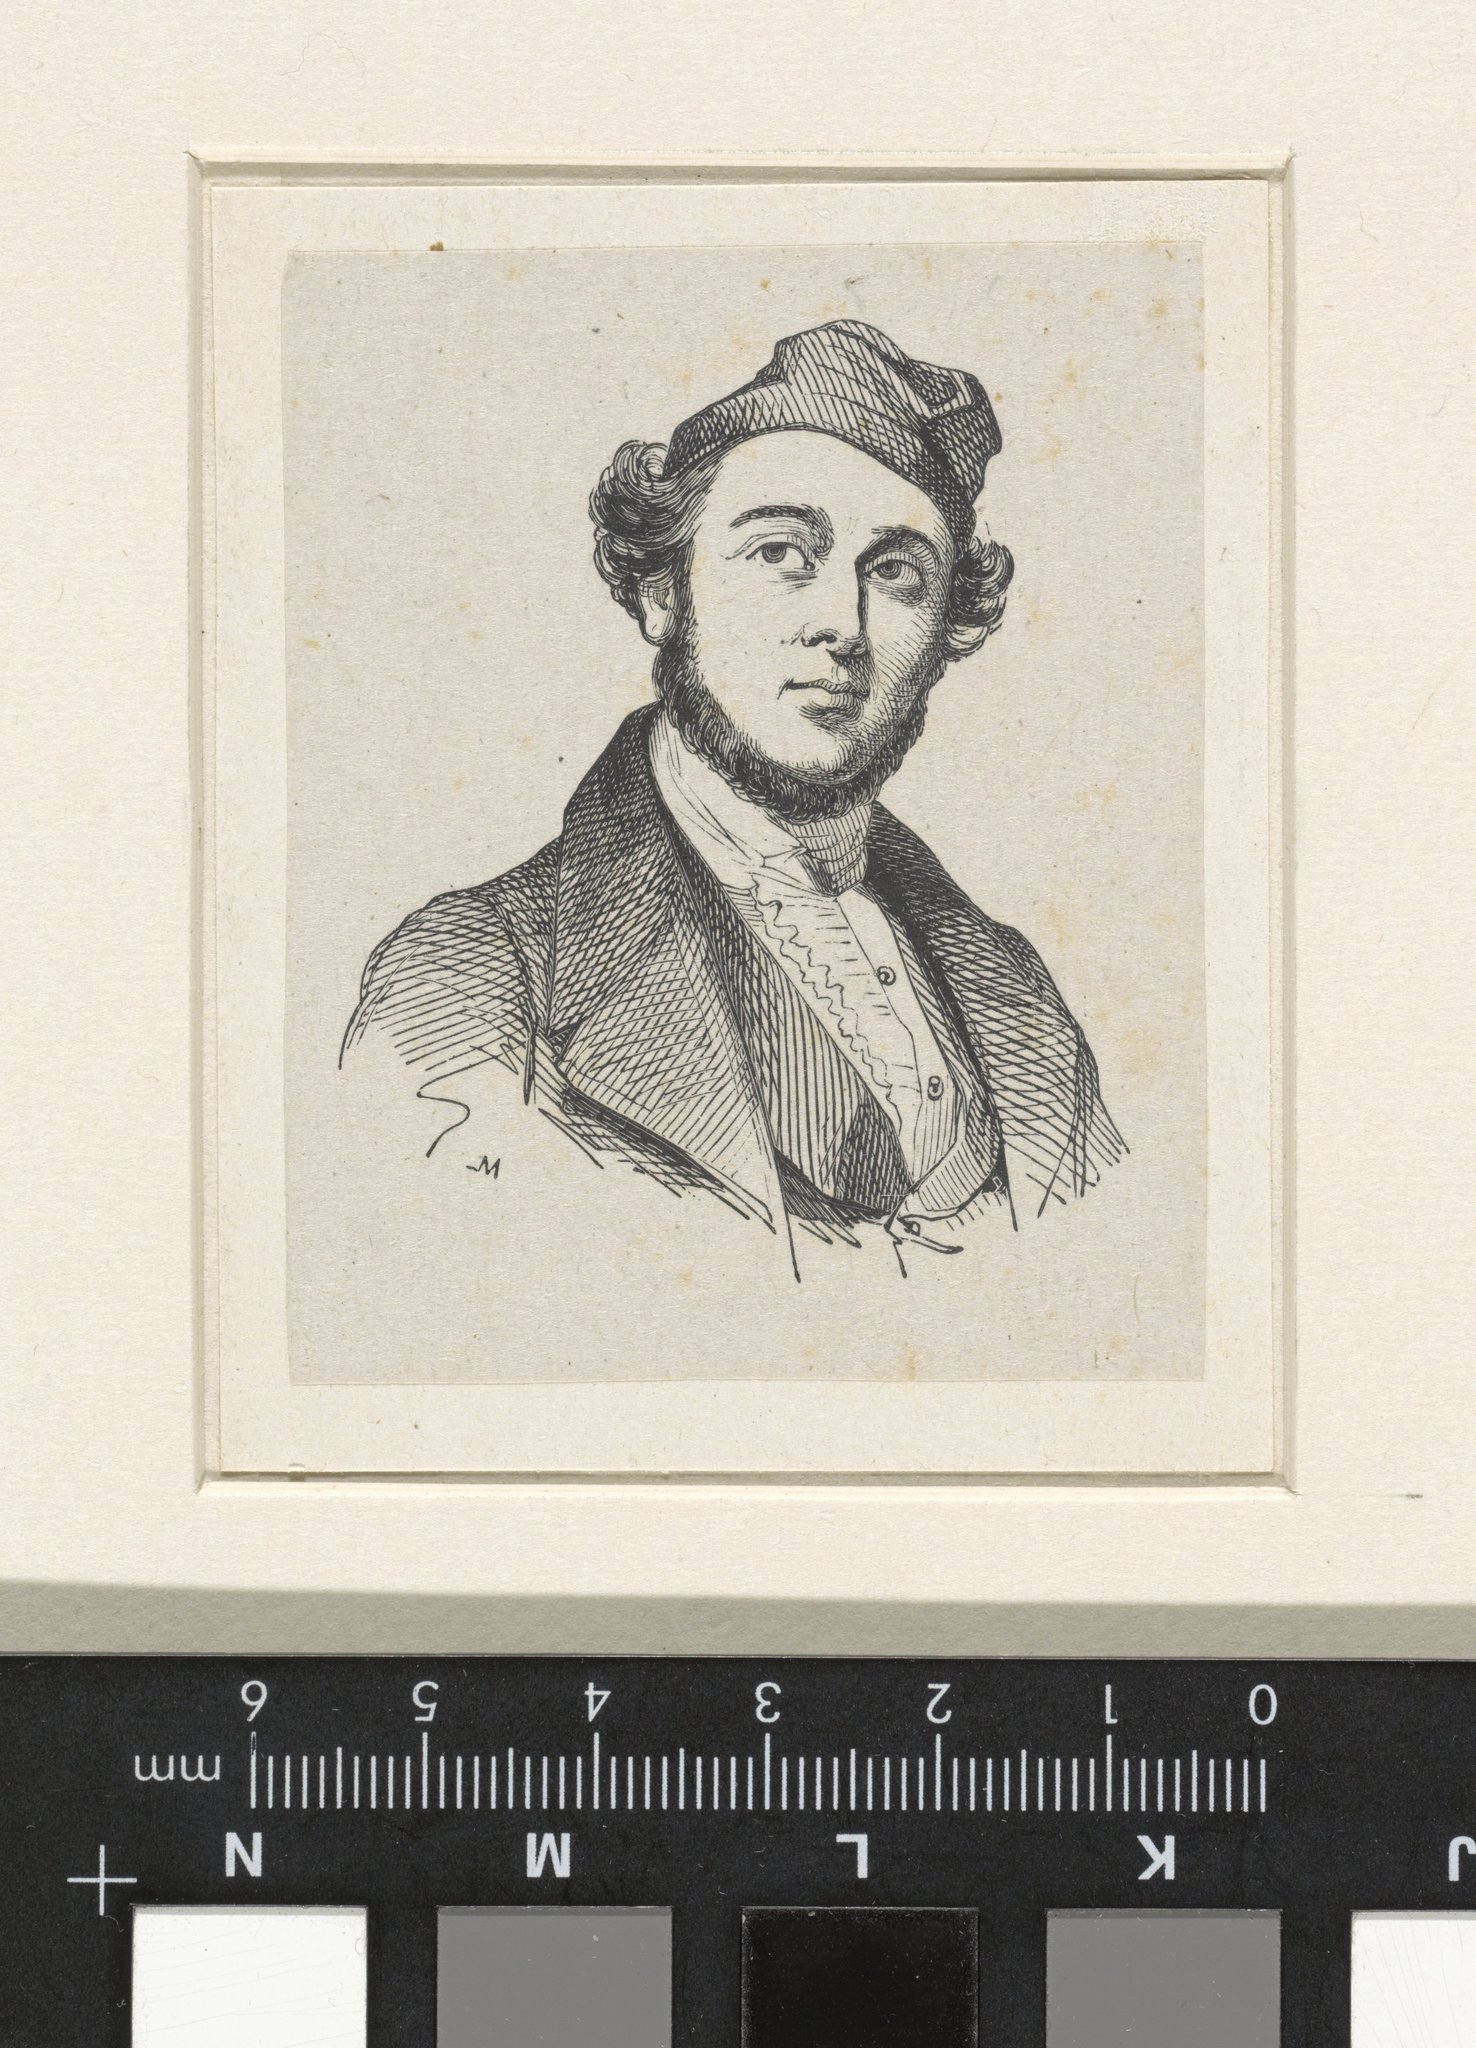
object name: print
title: Portret van Petrus van Schendel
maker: Anonymous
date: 1841-1921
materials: paper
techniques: engraving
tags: brussels, draughtsman, petrus van schendel, portrait, self-portrait of artist